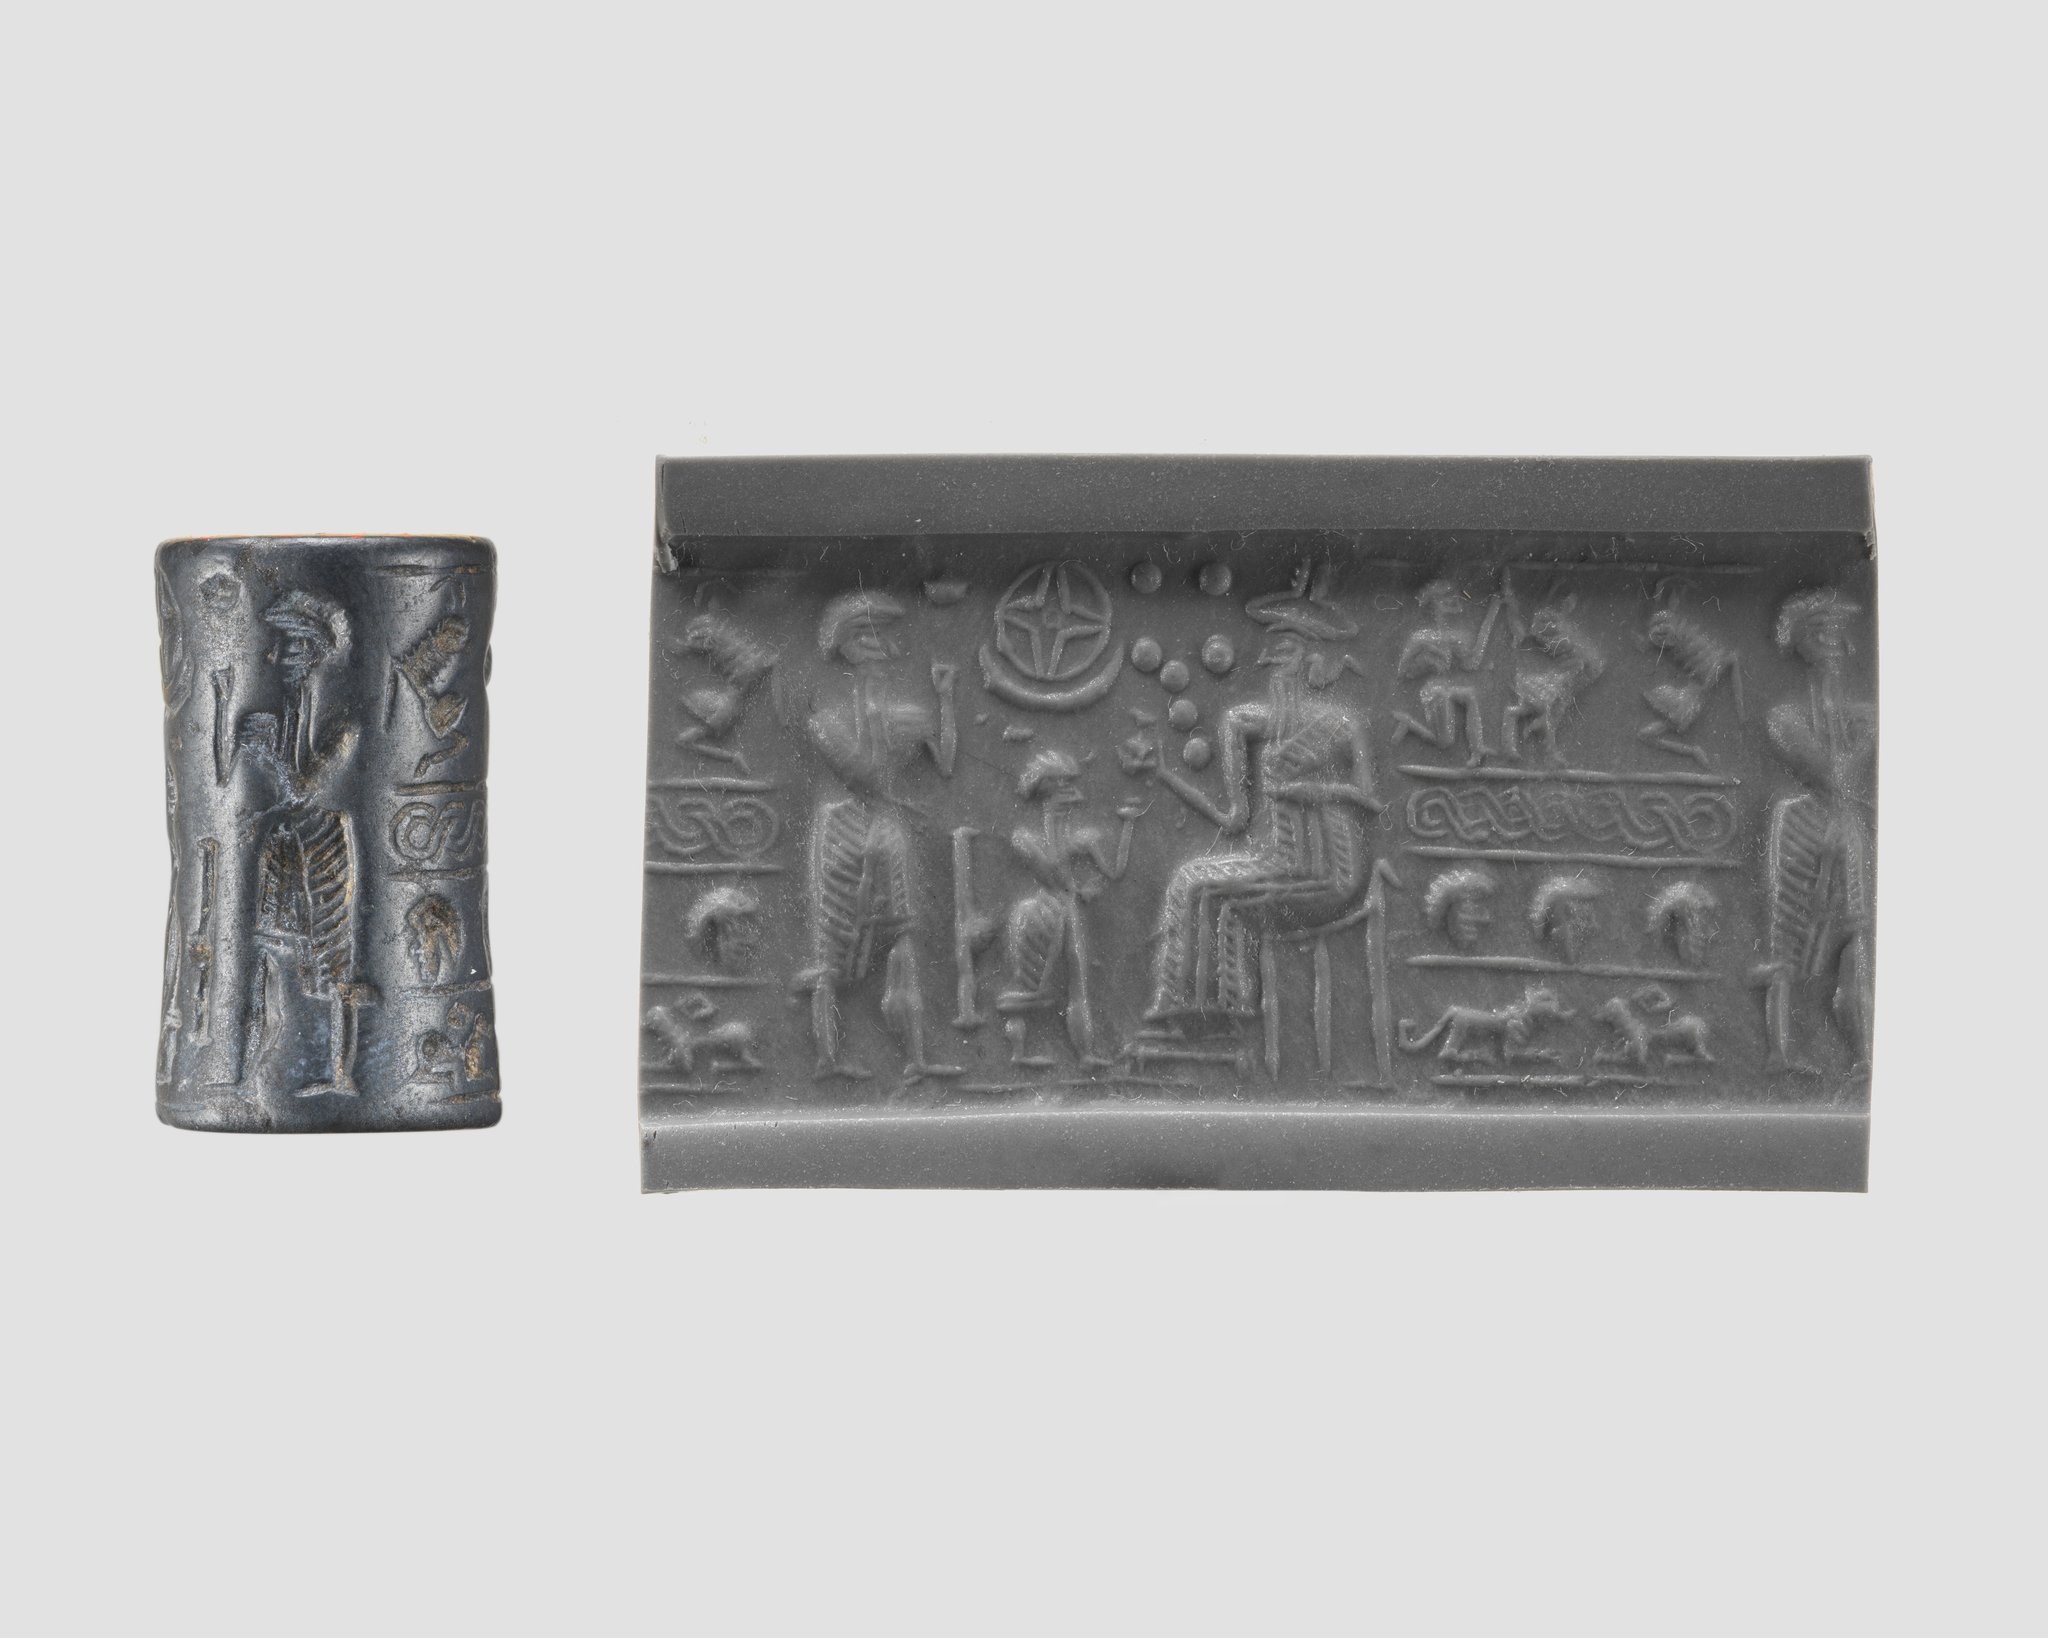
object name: cylinder seal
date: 1820-1730 BCE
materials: mineral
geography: syria